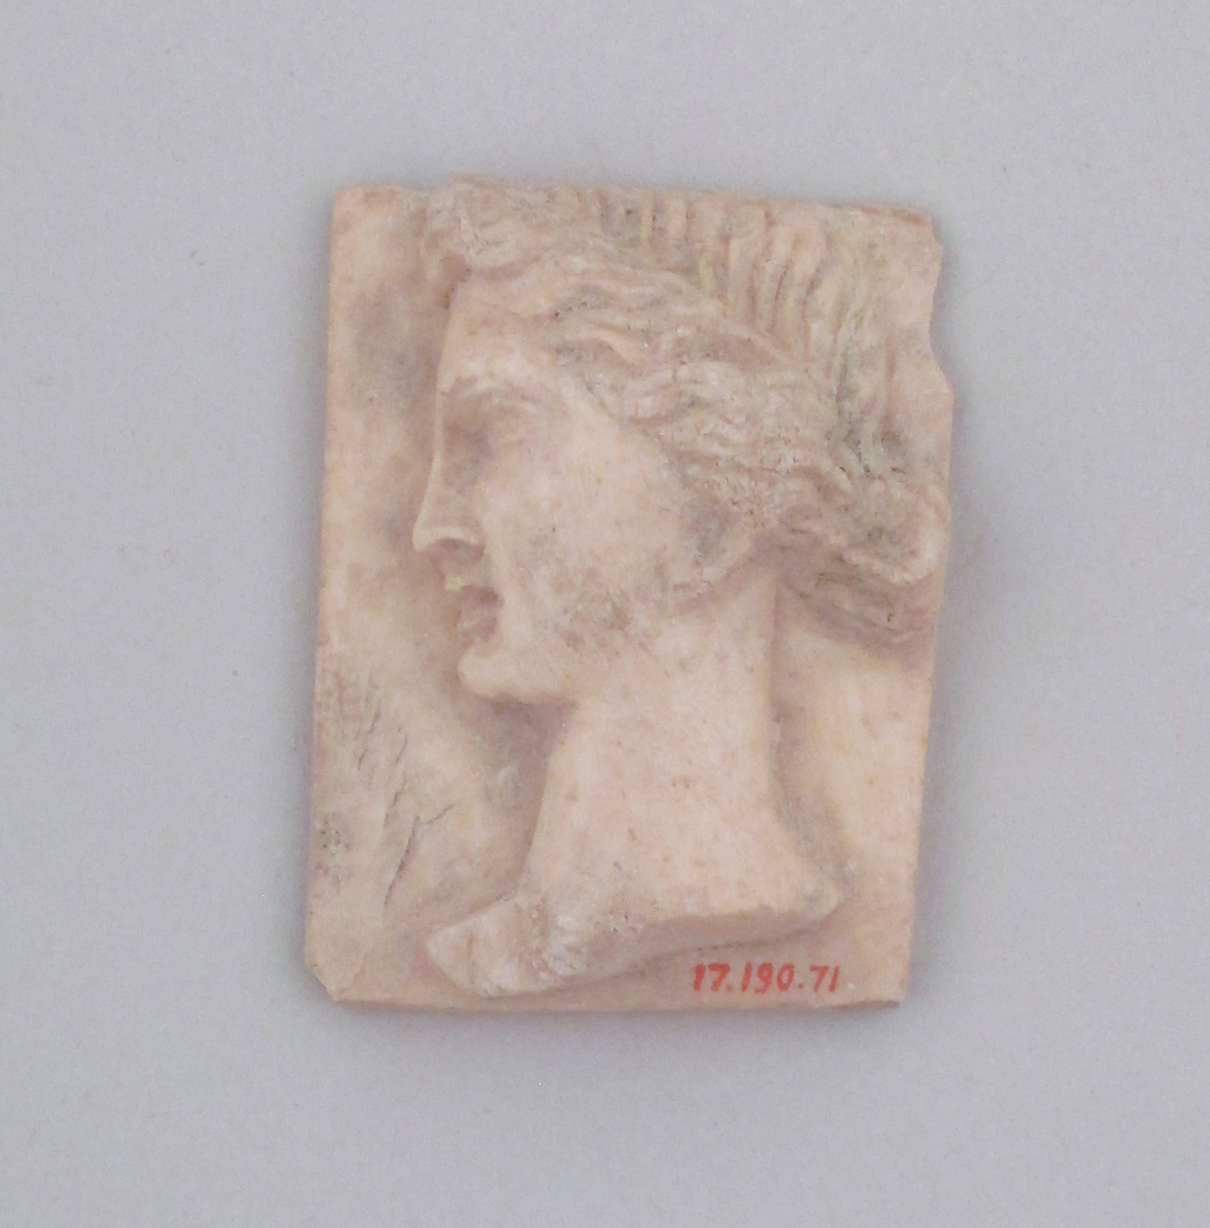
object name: relief of a head of woman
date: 7000 BCE-330 CE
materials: ivory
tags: heads,profiles,women